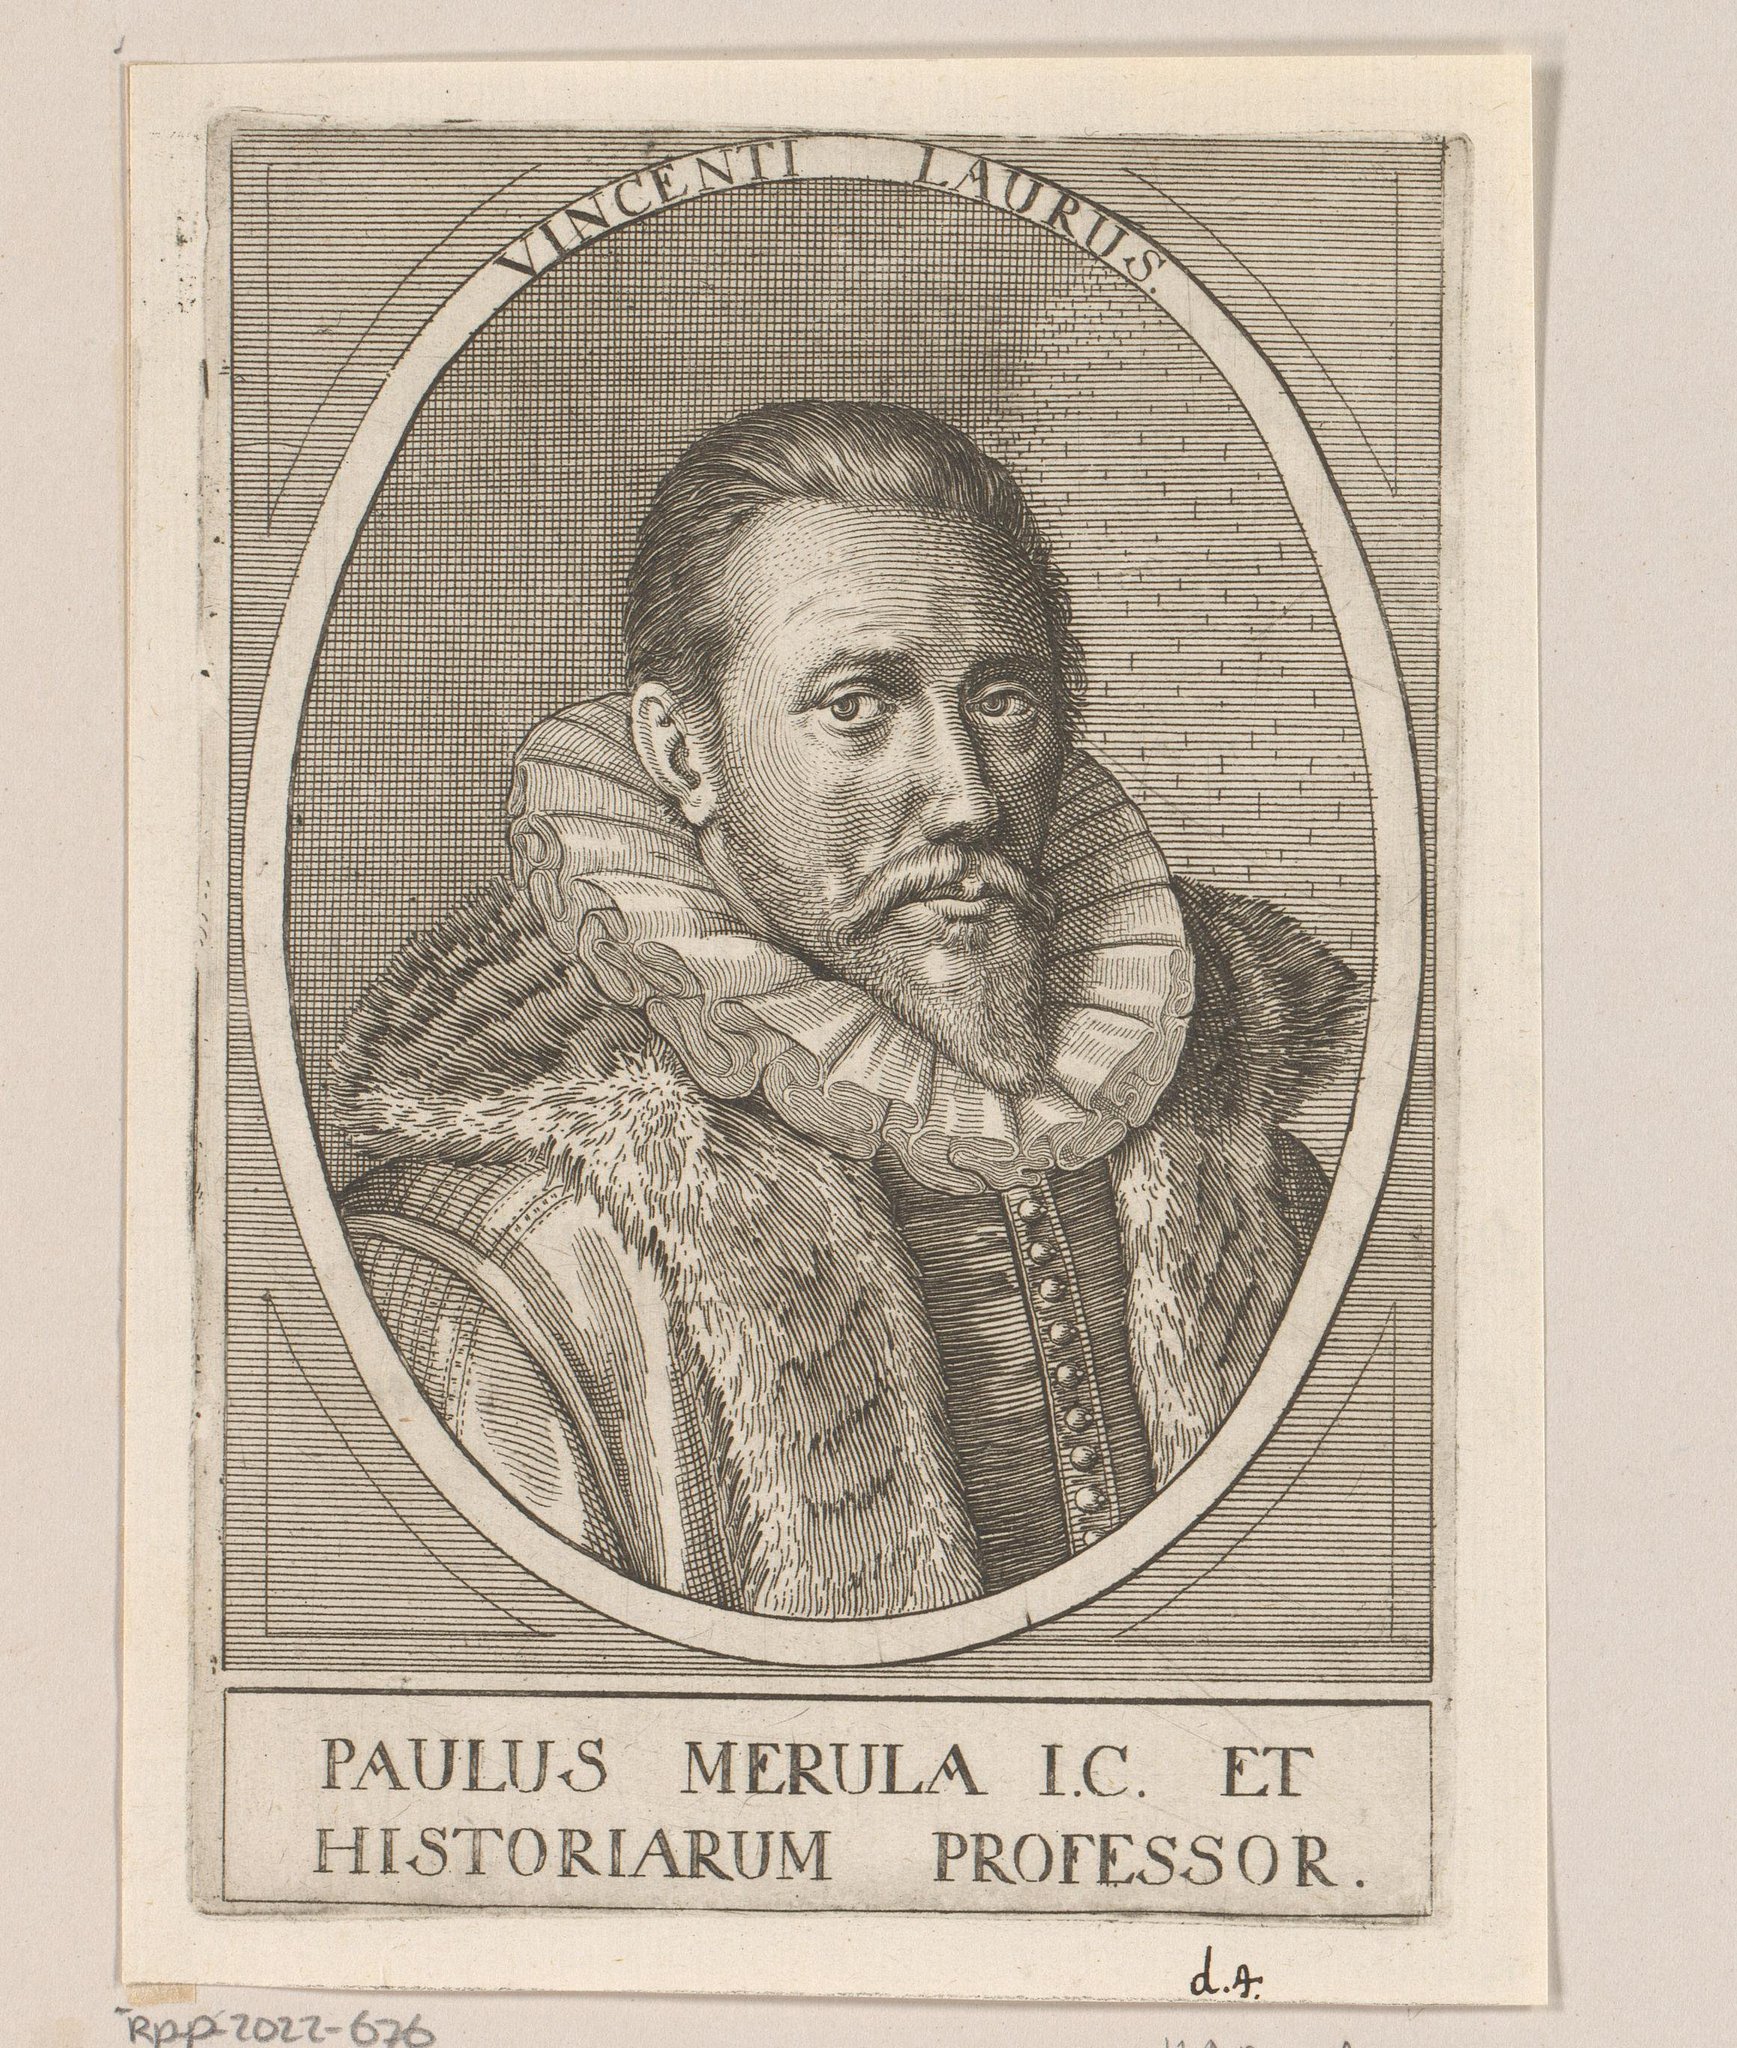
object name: print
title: Paulus Merula I.C.et Historiarum Professor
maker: sebastian furck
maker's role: print maker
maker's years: 1600-1655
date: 1612-1650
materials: paper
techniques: engraving, etching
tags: paulus merula, moustache, historical persons, beard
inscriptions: inscription: ‘Franciscus [...] aure mala.’, inscription: ‘d.4.’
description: Andere staat prent met 'd4' rechtsonder gebruikt in: Boissard, Jean Jacques. Bibliotheca chalcographica (...) VI pars. Frankfurt am Main: Johannes Ammon, 1650.